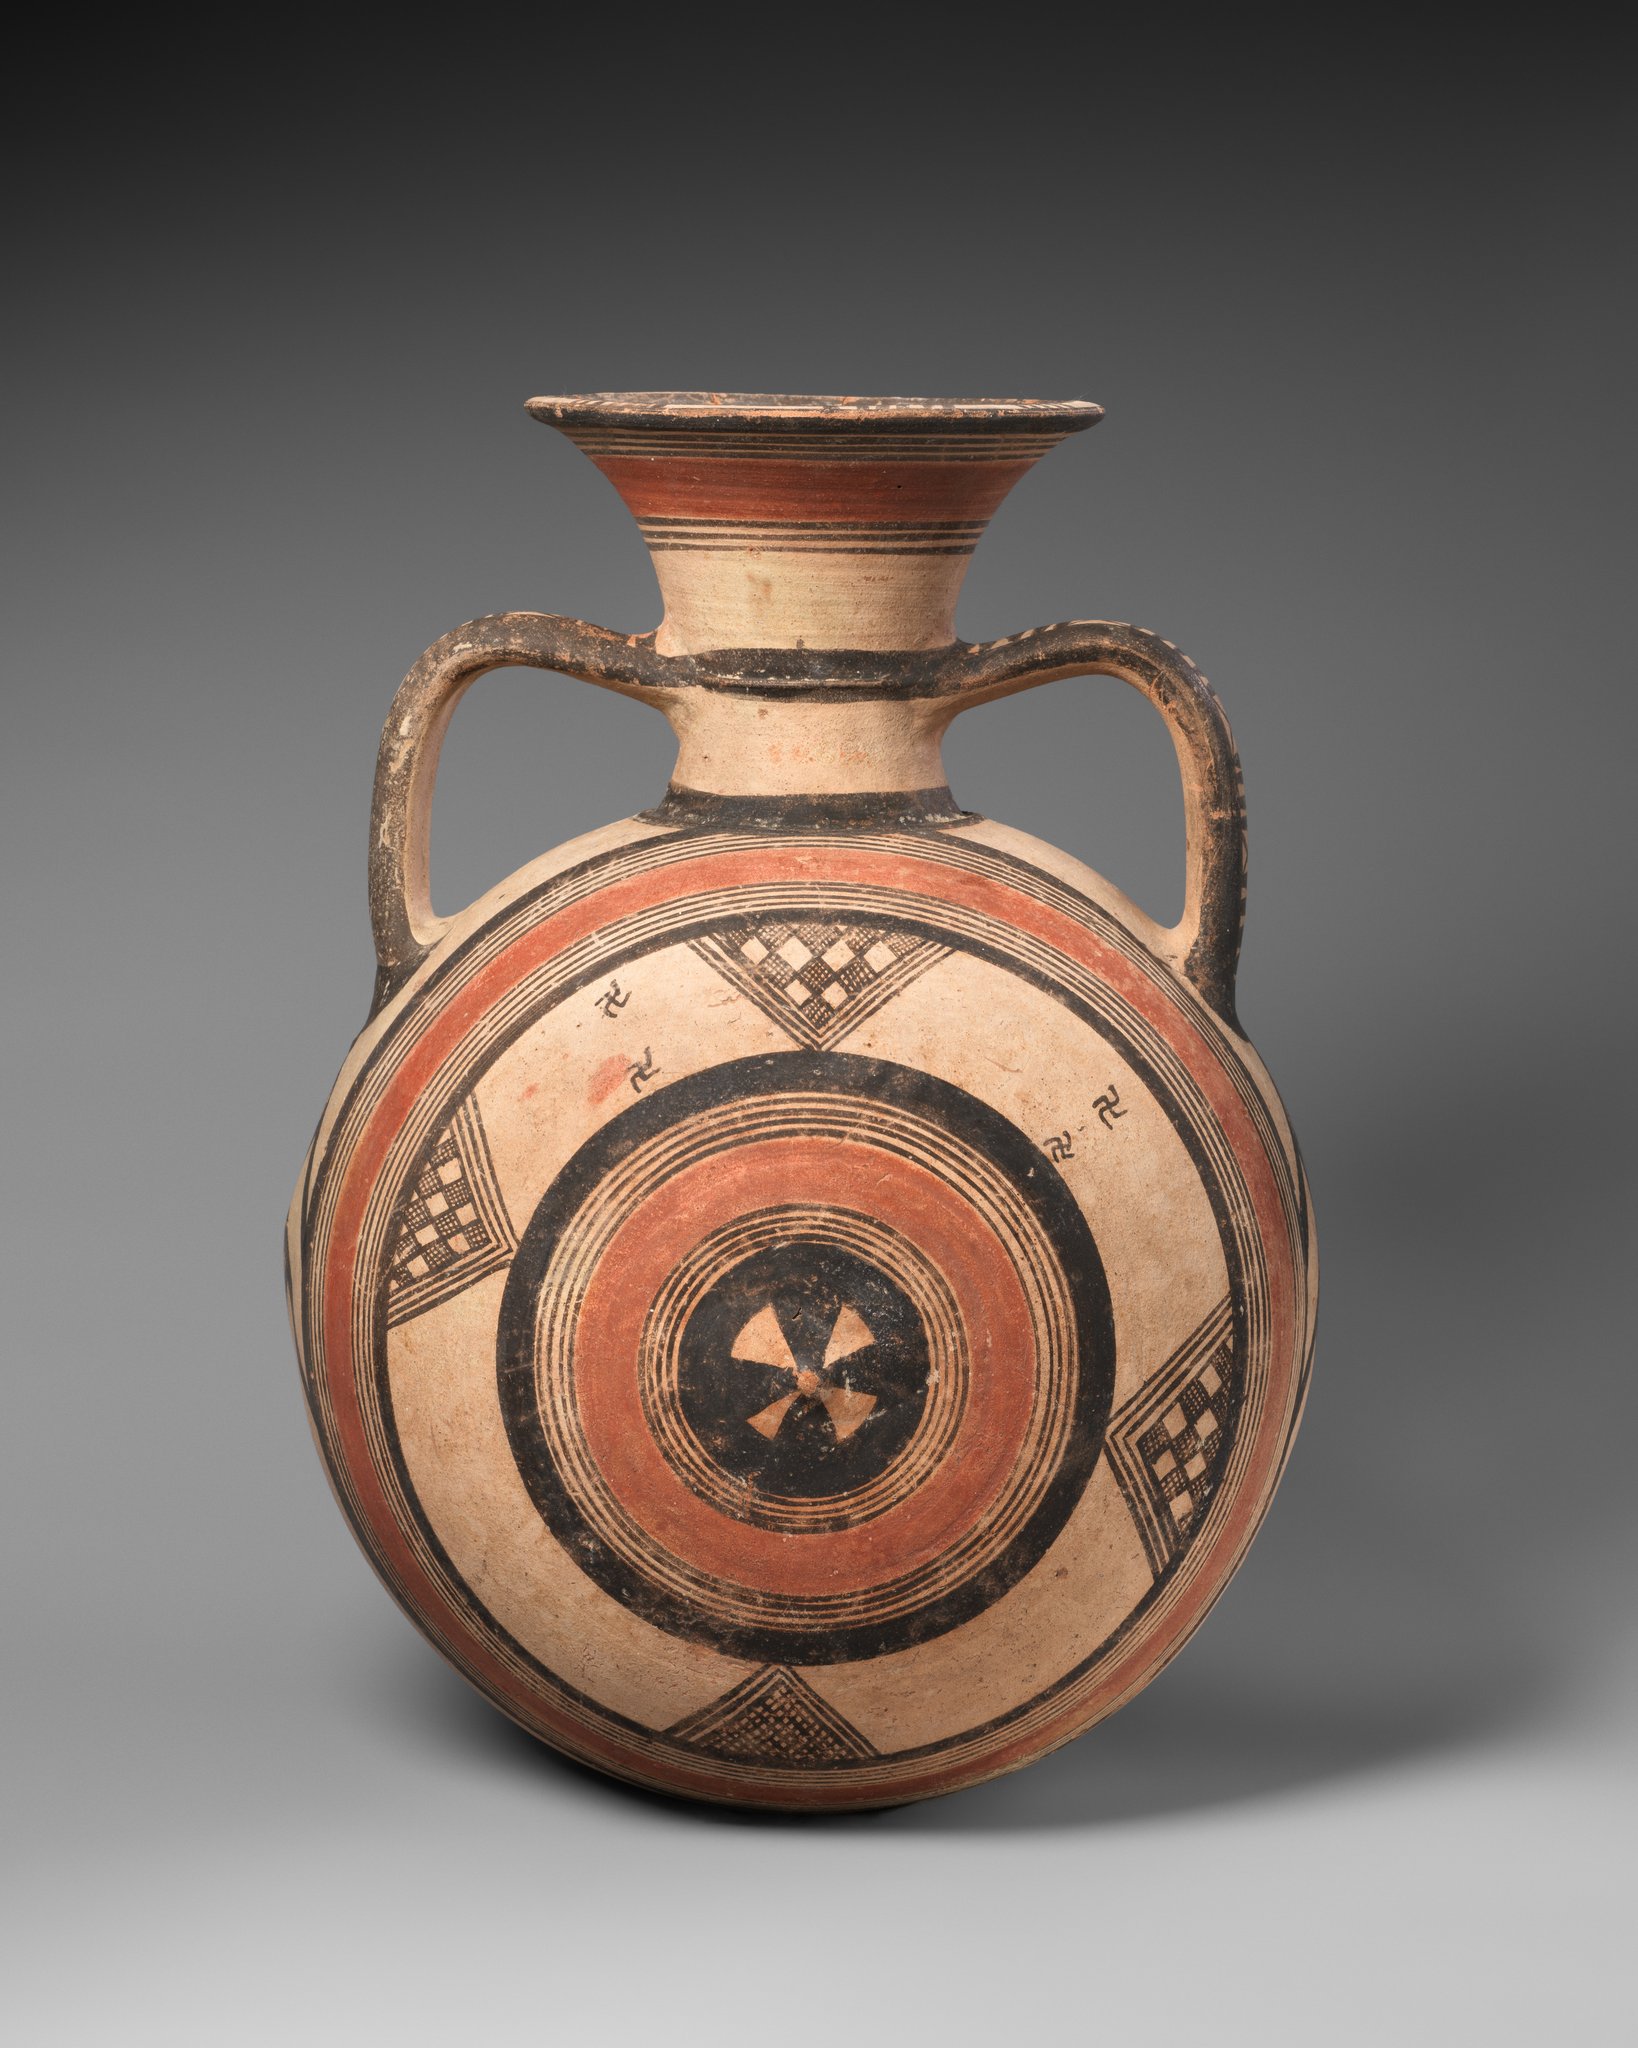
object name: jar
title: Terracotta jar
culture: cypriot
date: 850-750 BCE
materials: terracotta